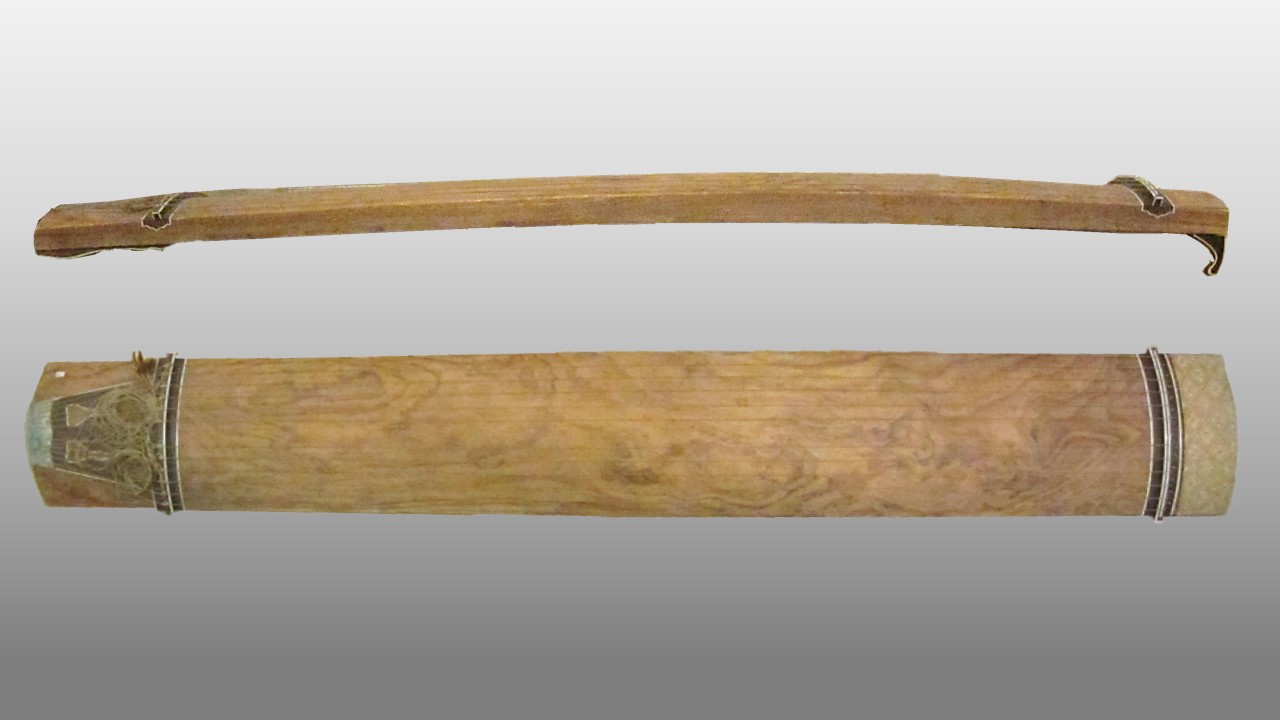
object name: yamada koto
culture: japanese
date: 1801-1900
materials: ivory, metal, silk, wood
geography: japan